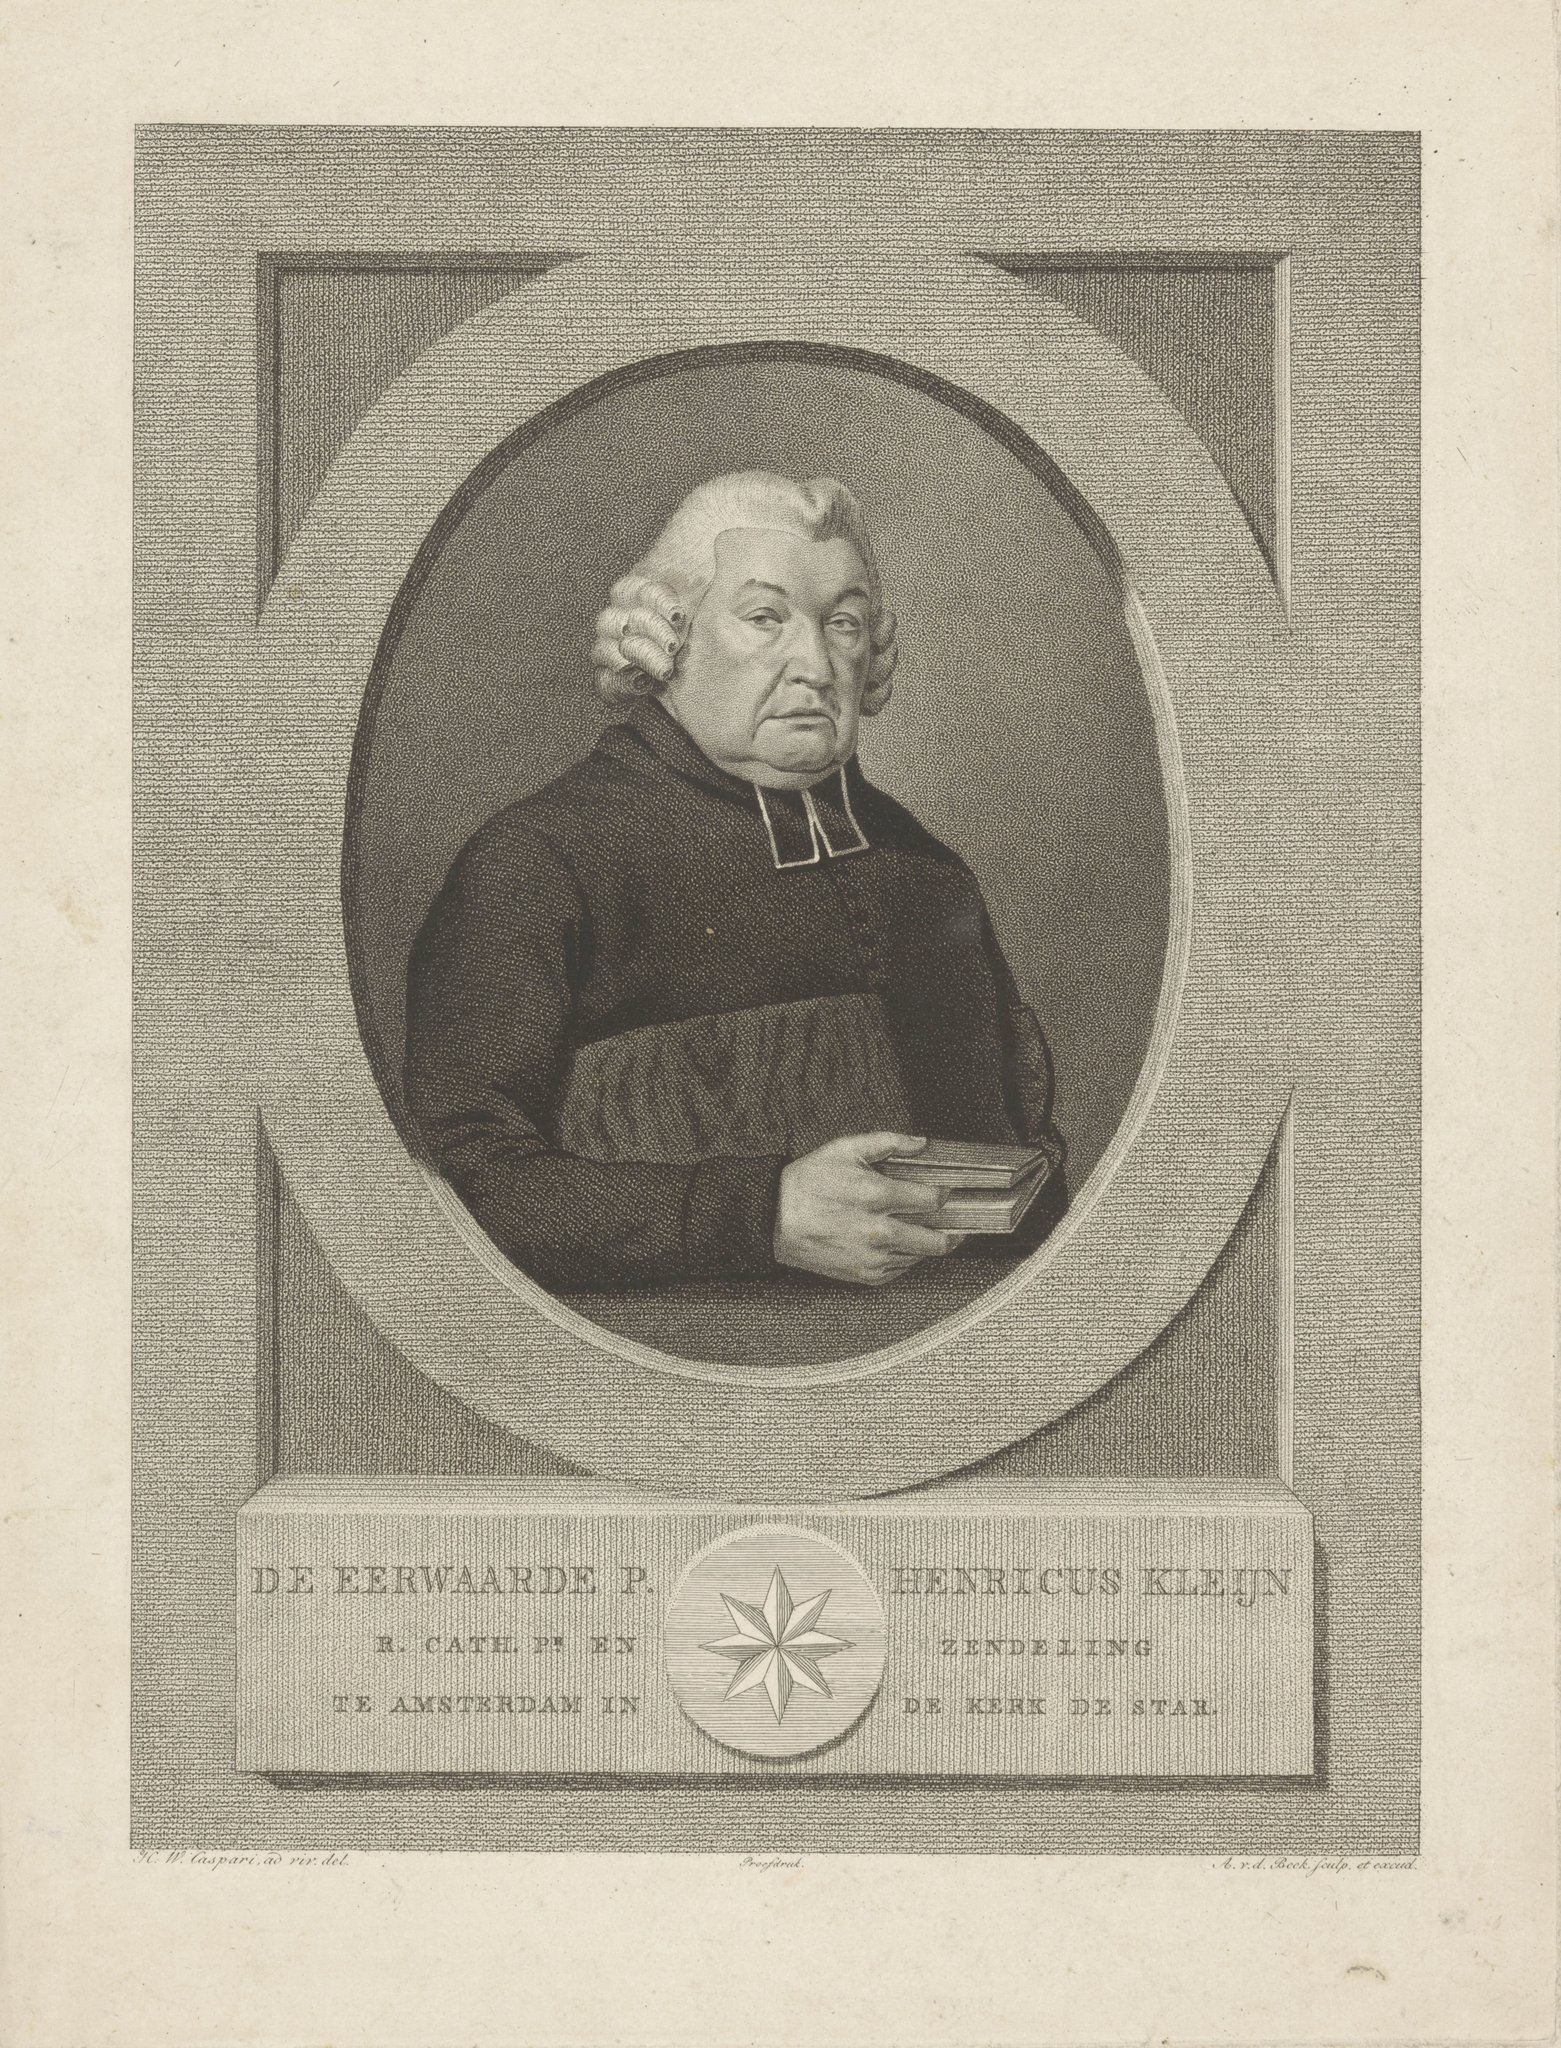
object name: print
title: De eerwaarde P. (...) kerk de Star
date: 1793-1852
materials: paper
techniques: aquatint, etching, roulette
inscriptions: collector's mark: Lugt 2228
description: Prent naar tekening van Hendrik Willem Caspari.